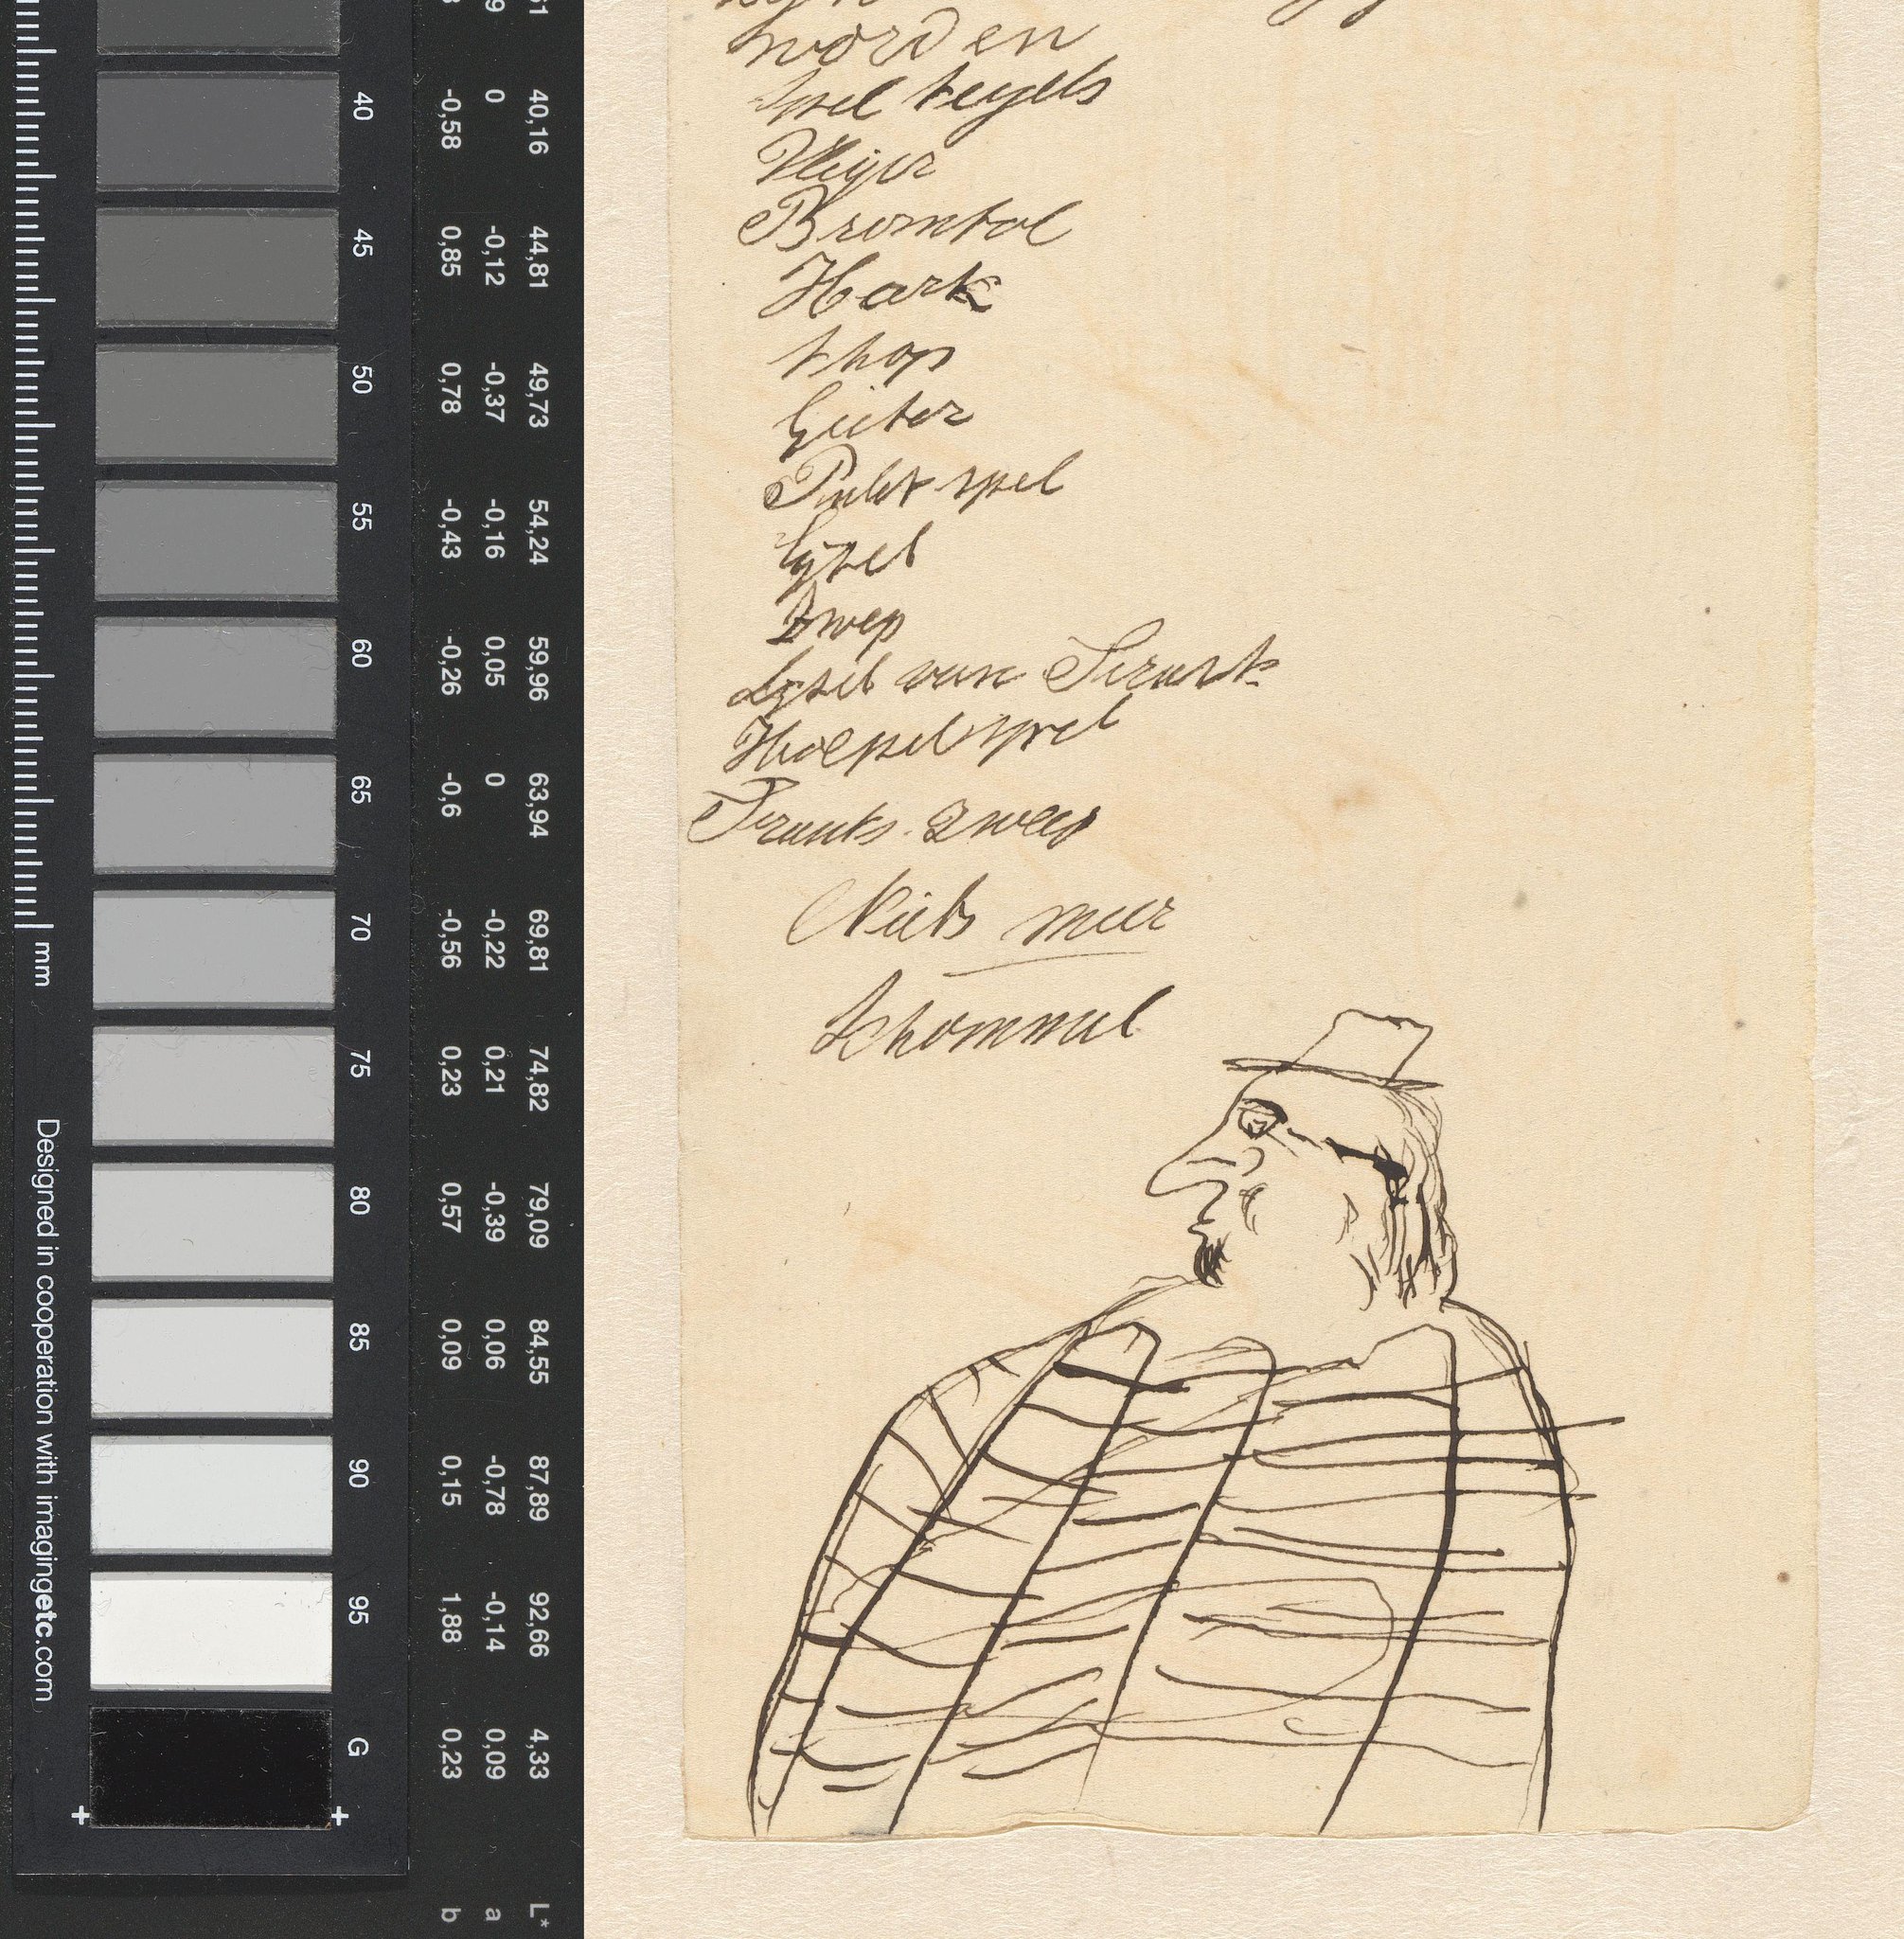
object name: drawing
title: Kindertekening met notities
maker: joannes carolus alberdingk thijm (jan)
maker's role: pater, schrijver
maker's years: 1847-1926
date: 1855-1860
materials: ink, paper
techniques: pen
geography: netherlands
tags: head-gear